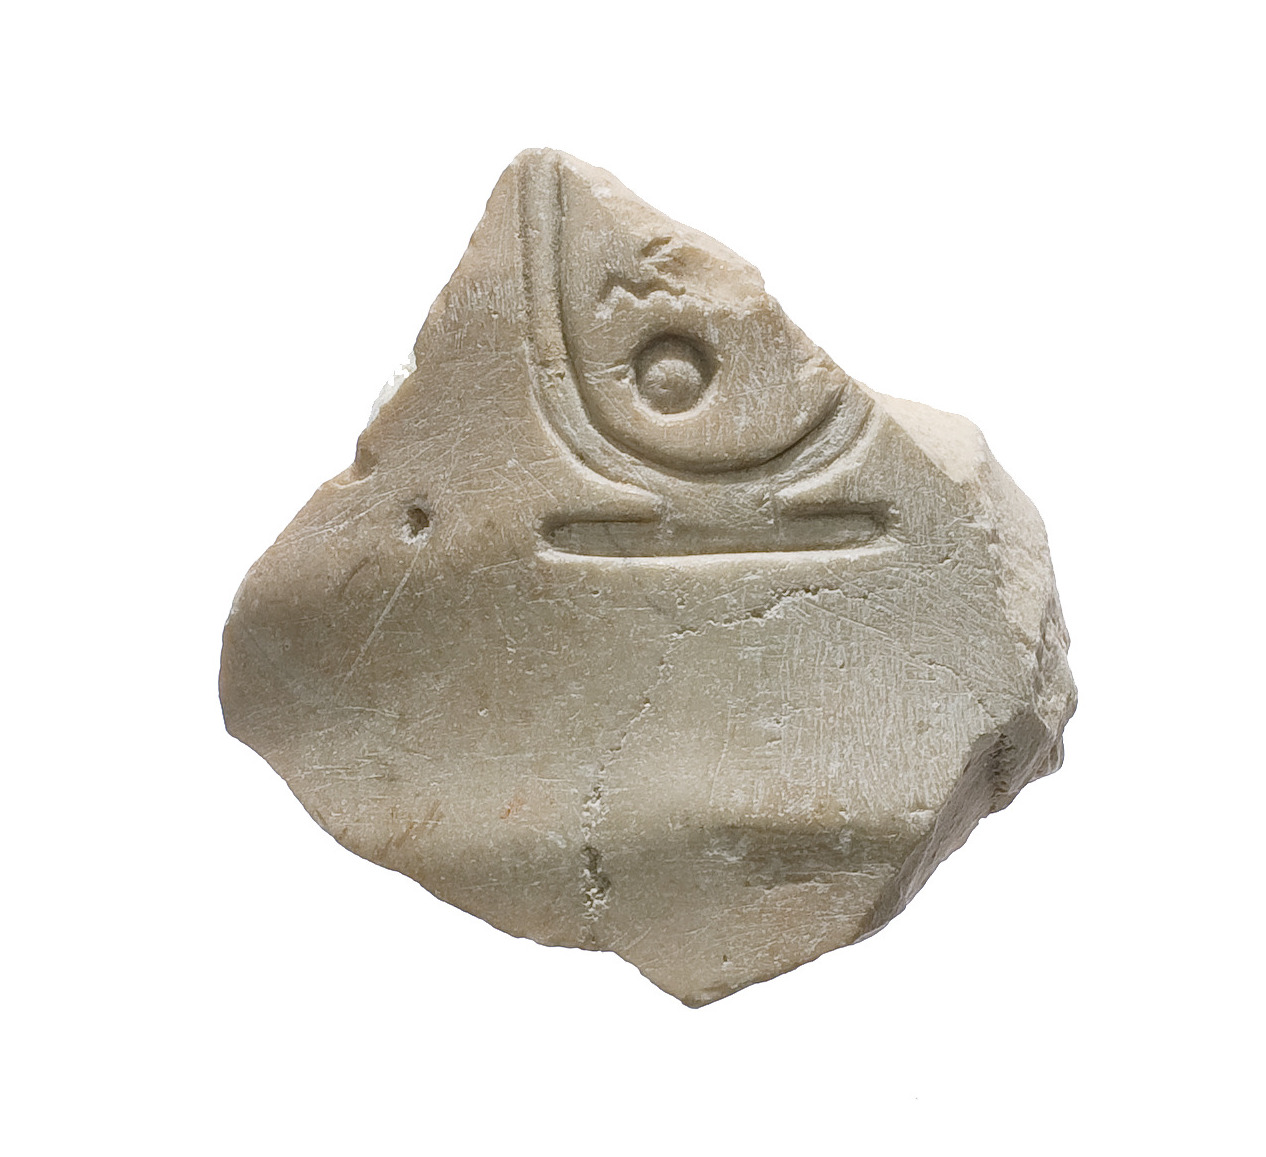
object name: arm with garment fragment, cartouche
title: Arm with garment, Aten cartouche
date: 1353-1336 BCE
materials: limestone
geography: egypt